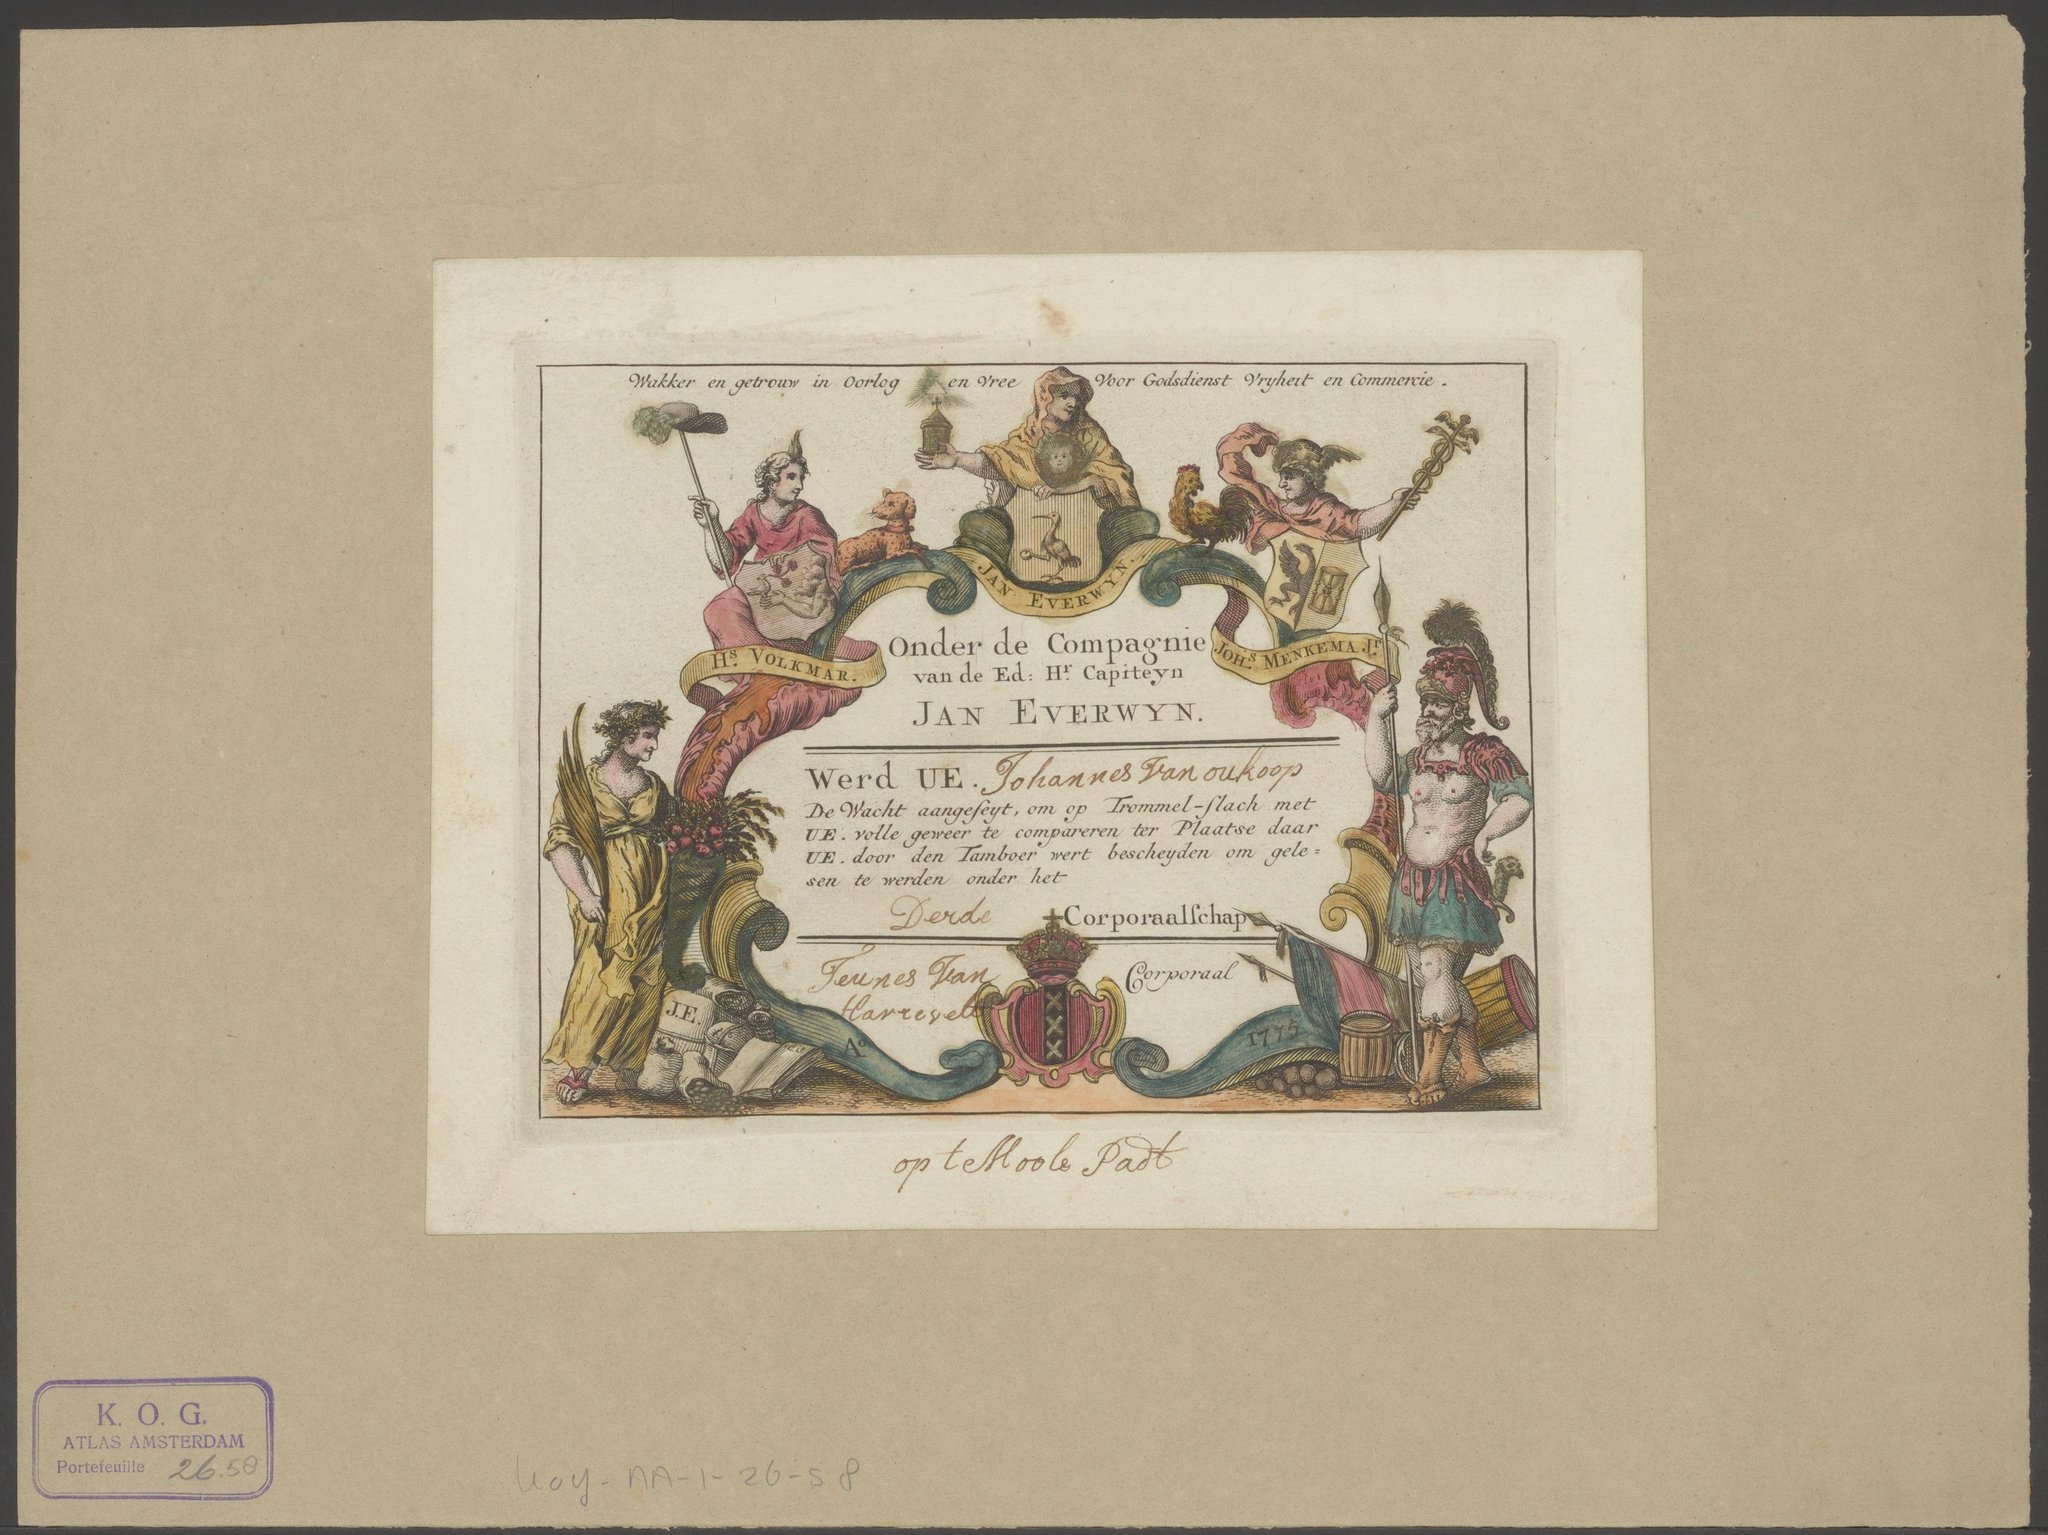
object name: print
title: Schuttersbrief van kapitein Jan Everwyn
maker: Anonymous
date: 1775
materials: paper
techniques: engraving, etching, hand coloring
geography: northern netherlands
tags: coat of arms (as symbol of the state, etc.) (+ city; municipal), symbols, allegories of peace, 'pax'; 'pace' (ripa), allegorical representations ~ religion; 'religione', 'religione de ss. mauritio e lazaro', 'religione vera christiana' (ripa), symbols, allegories of war; 'guerra' (ripa), freedom, liberty; 'libertà' (ripa), allegory of trade; 'commertio della vita humana' (ripa), armorial bearing, heraldry, amsterdam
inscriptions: collector's mark: Lugt 1641b, signature: ‘J.E.’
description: Schuttersbrief met oproep van kapitein Jan Everwyn, gericht aan Johannes van Oukoop, om zich bij het derde korporaalschap van Teunes van Harrevelt van de Amsterdamse schutterij te melden. Voorgedrukte brief met open delen die in pen zijn ingevuld. Onderwerpsrubriek binnen de Atlas Amsterdam: Schutters-oproepingsbriefjes.